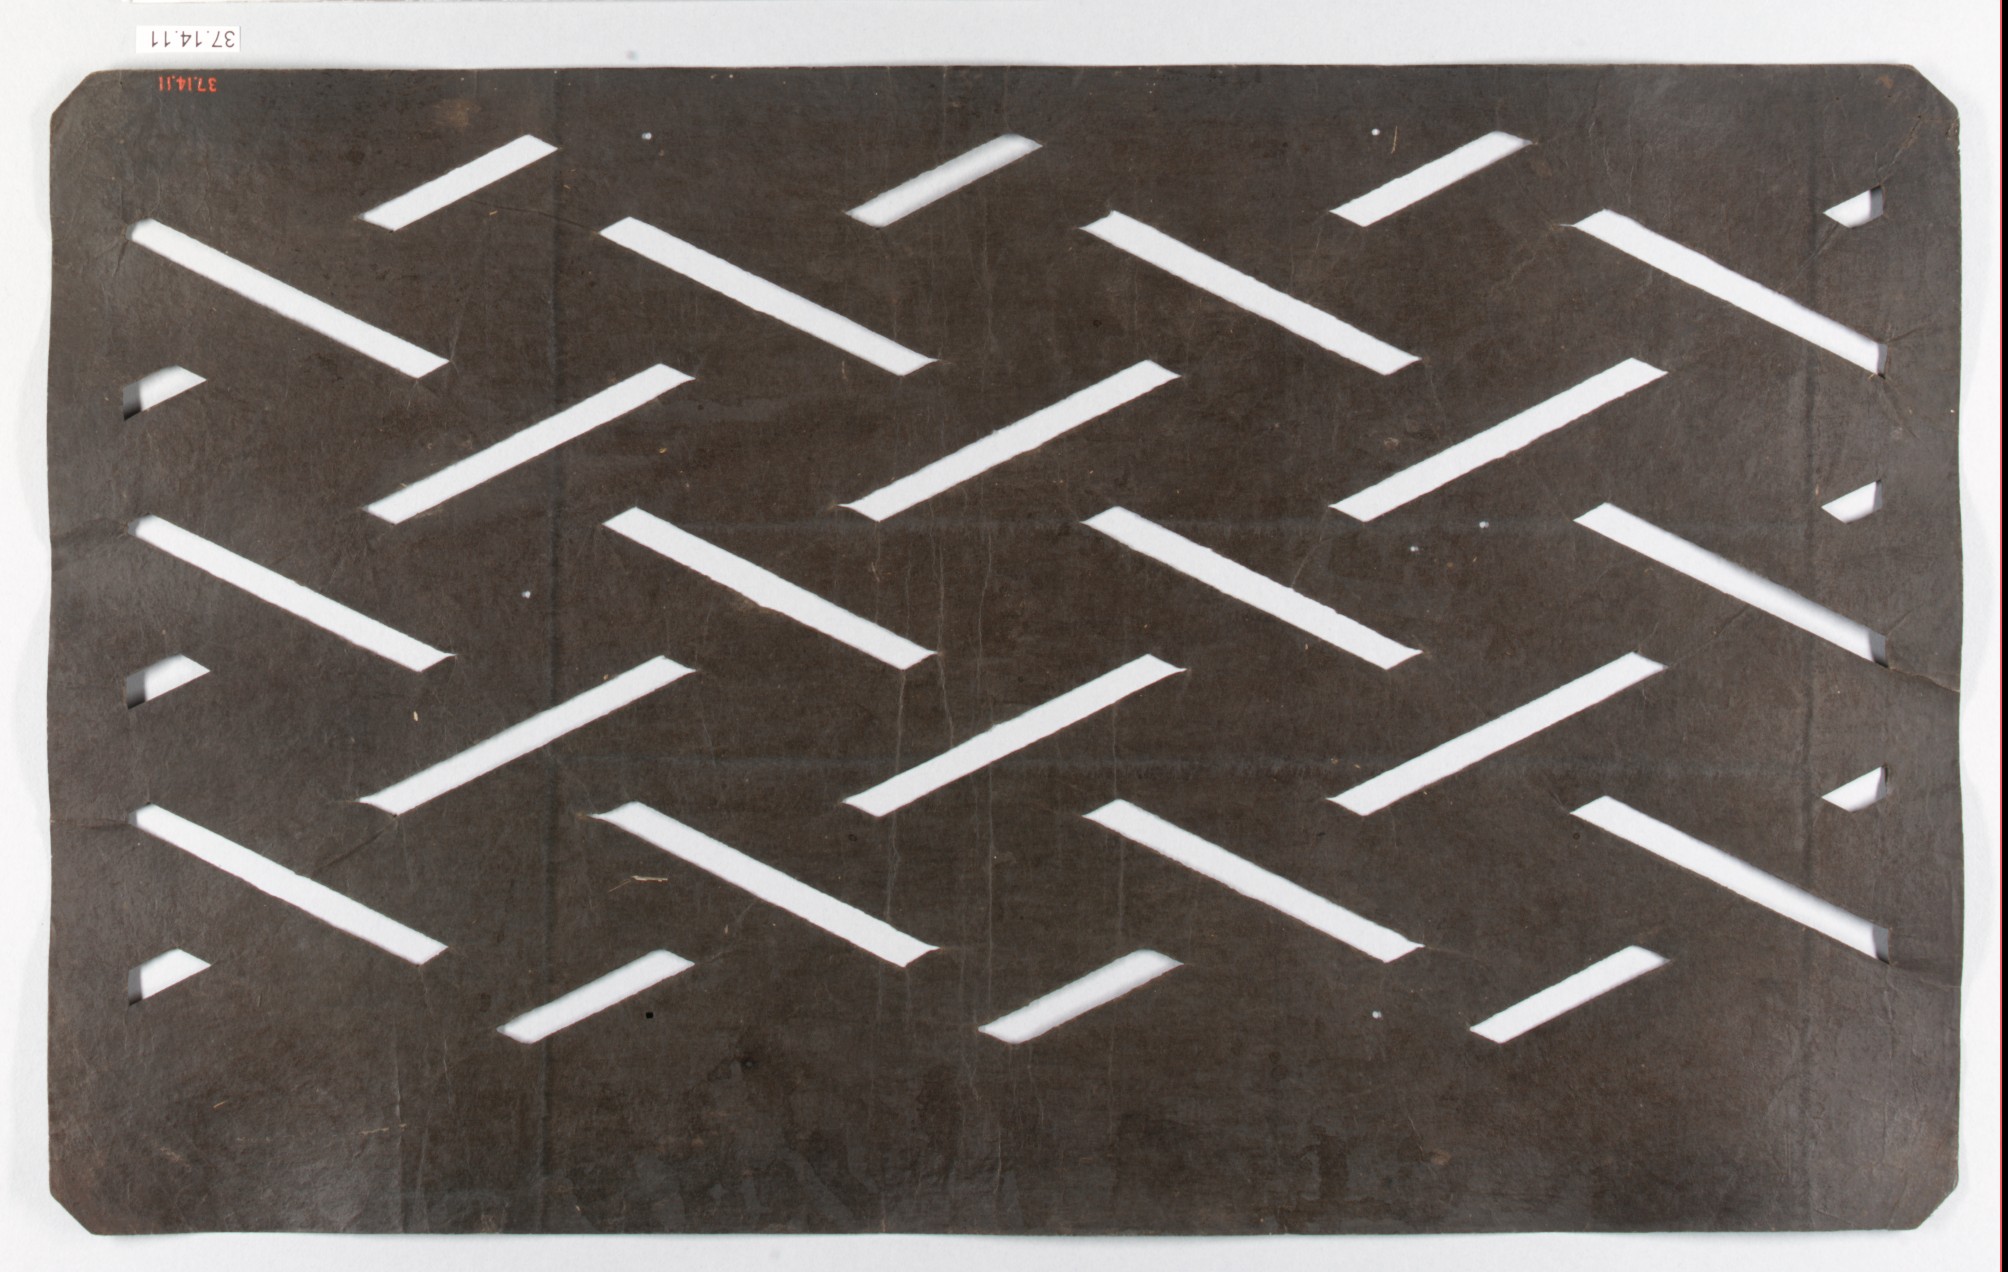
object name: stencil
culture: japanese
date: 1801-1900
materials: paper